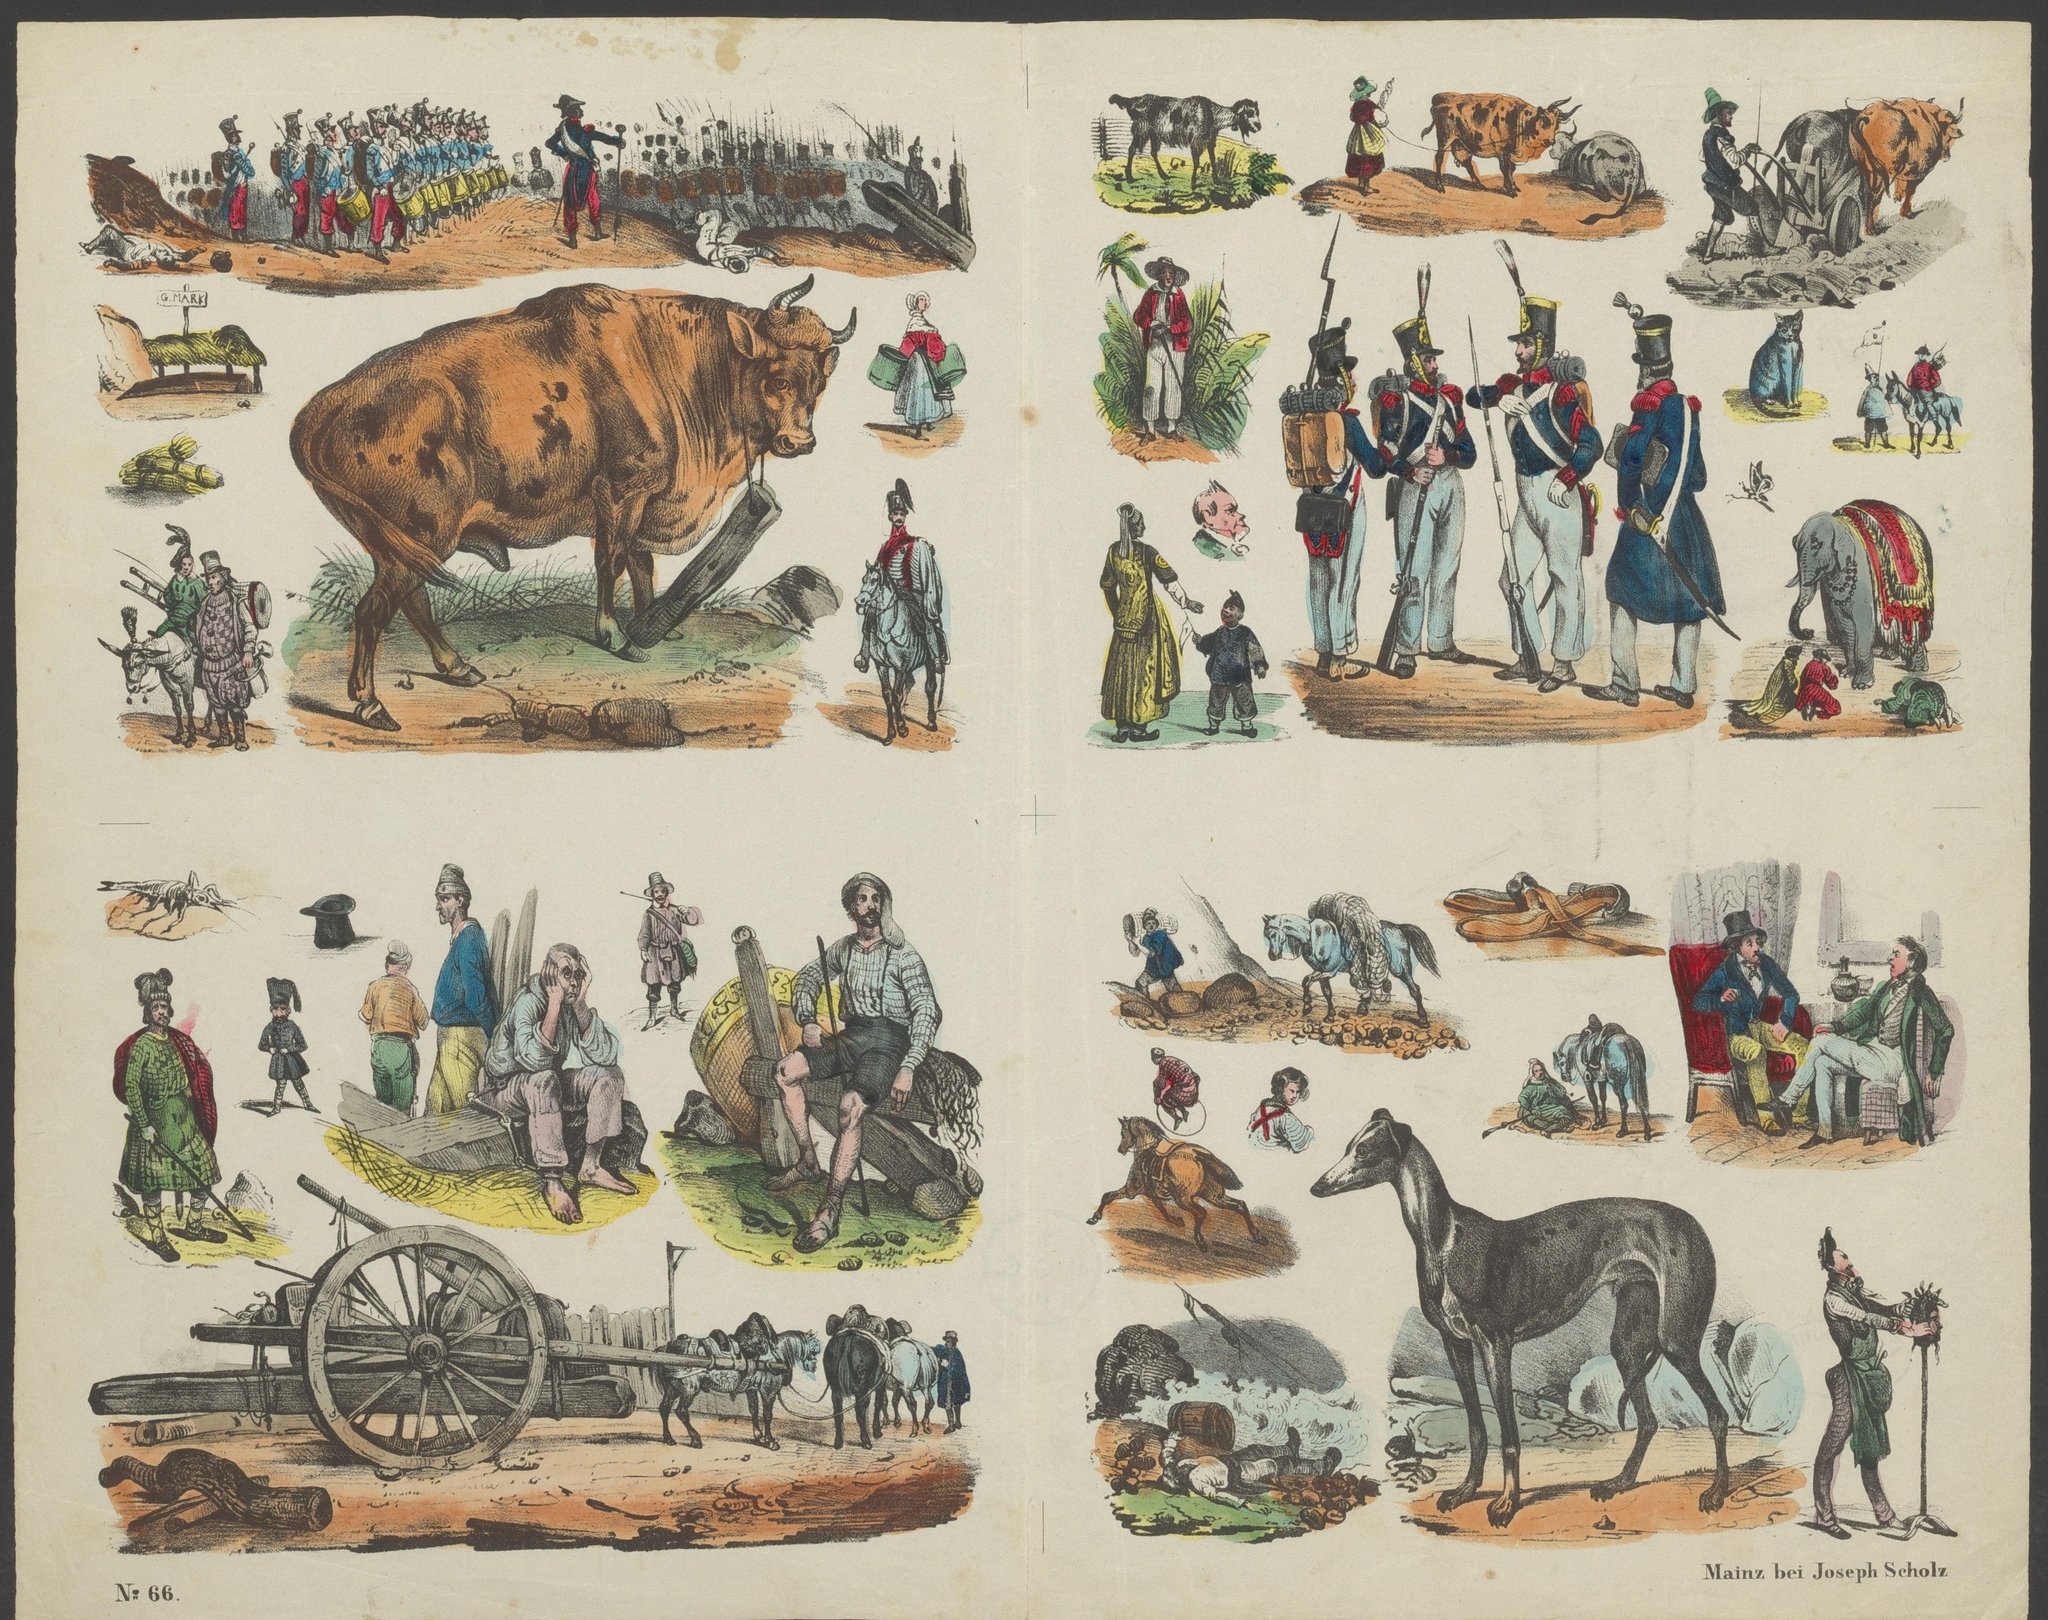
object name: popular print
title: Dieren, militairen en circusartiesten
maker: Anonymous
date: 1793-1813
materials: paper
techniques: hand coloring, lithograph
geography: mainz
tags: circus animals, elephants (circus performance), animals, warfare; military affairs, dogs (circus performance)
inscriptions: stamp, collector's mark: Lugt 1641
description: Linksonder genummerd: No. 66. Onderwerpsrubrieken binnen de Atlas Zeden en Gewoonten: Zeden en Gewoonten in Engeren Zin, Des menschen beging, midden en einde, Kinderleven – Kinderspel en Kinderprenten.